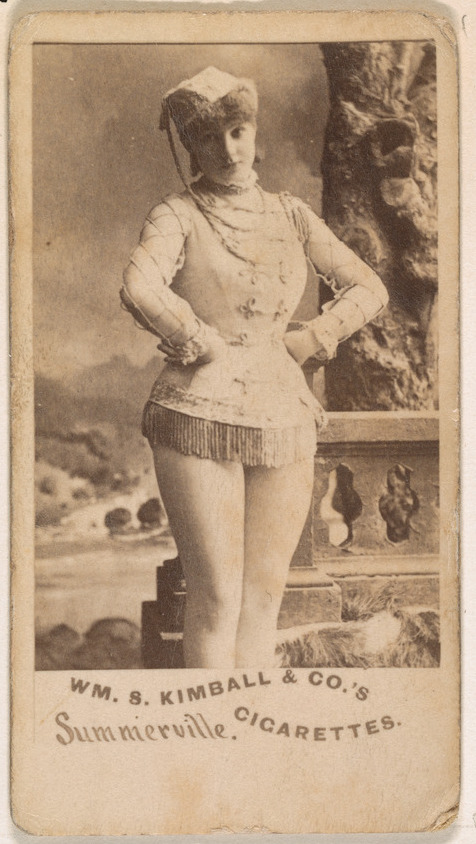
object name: photograph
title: Miss Summerville, from the Actresses series (N203) issued by Wm. S. Kimball & Co.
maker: william s. kimball & company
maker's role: publisher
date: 1889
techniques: color lithograph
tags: portraits,women,actresses